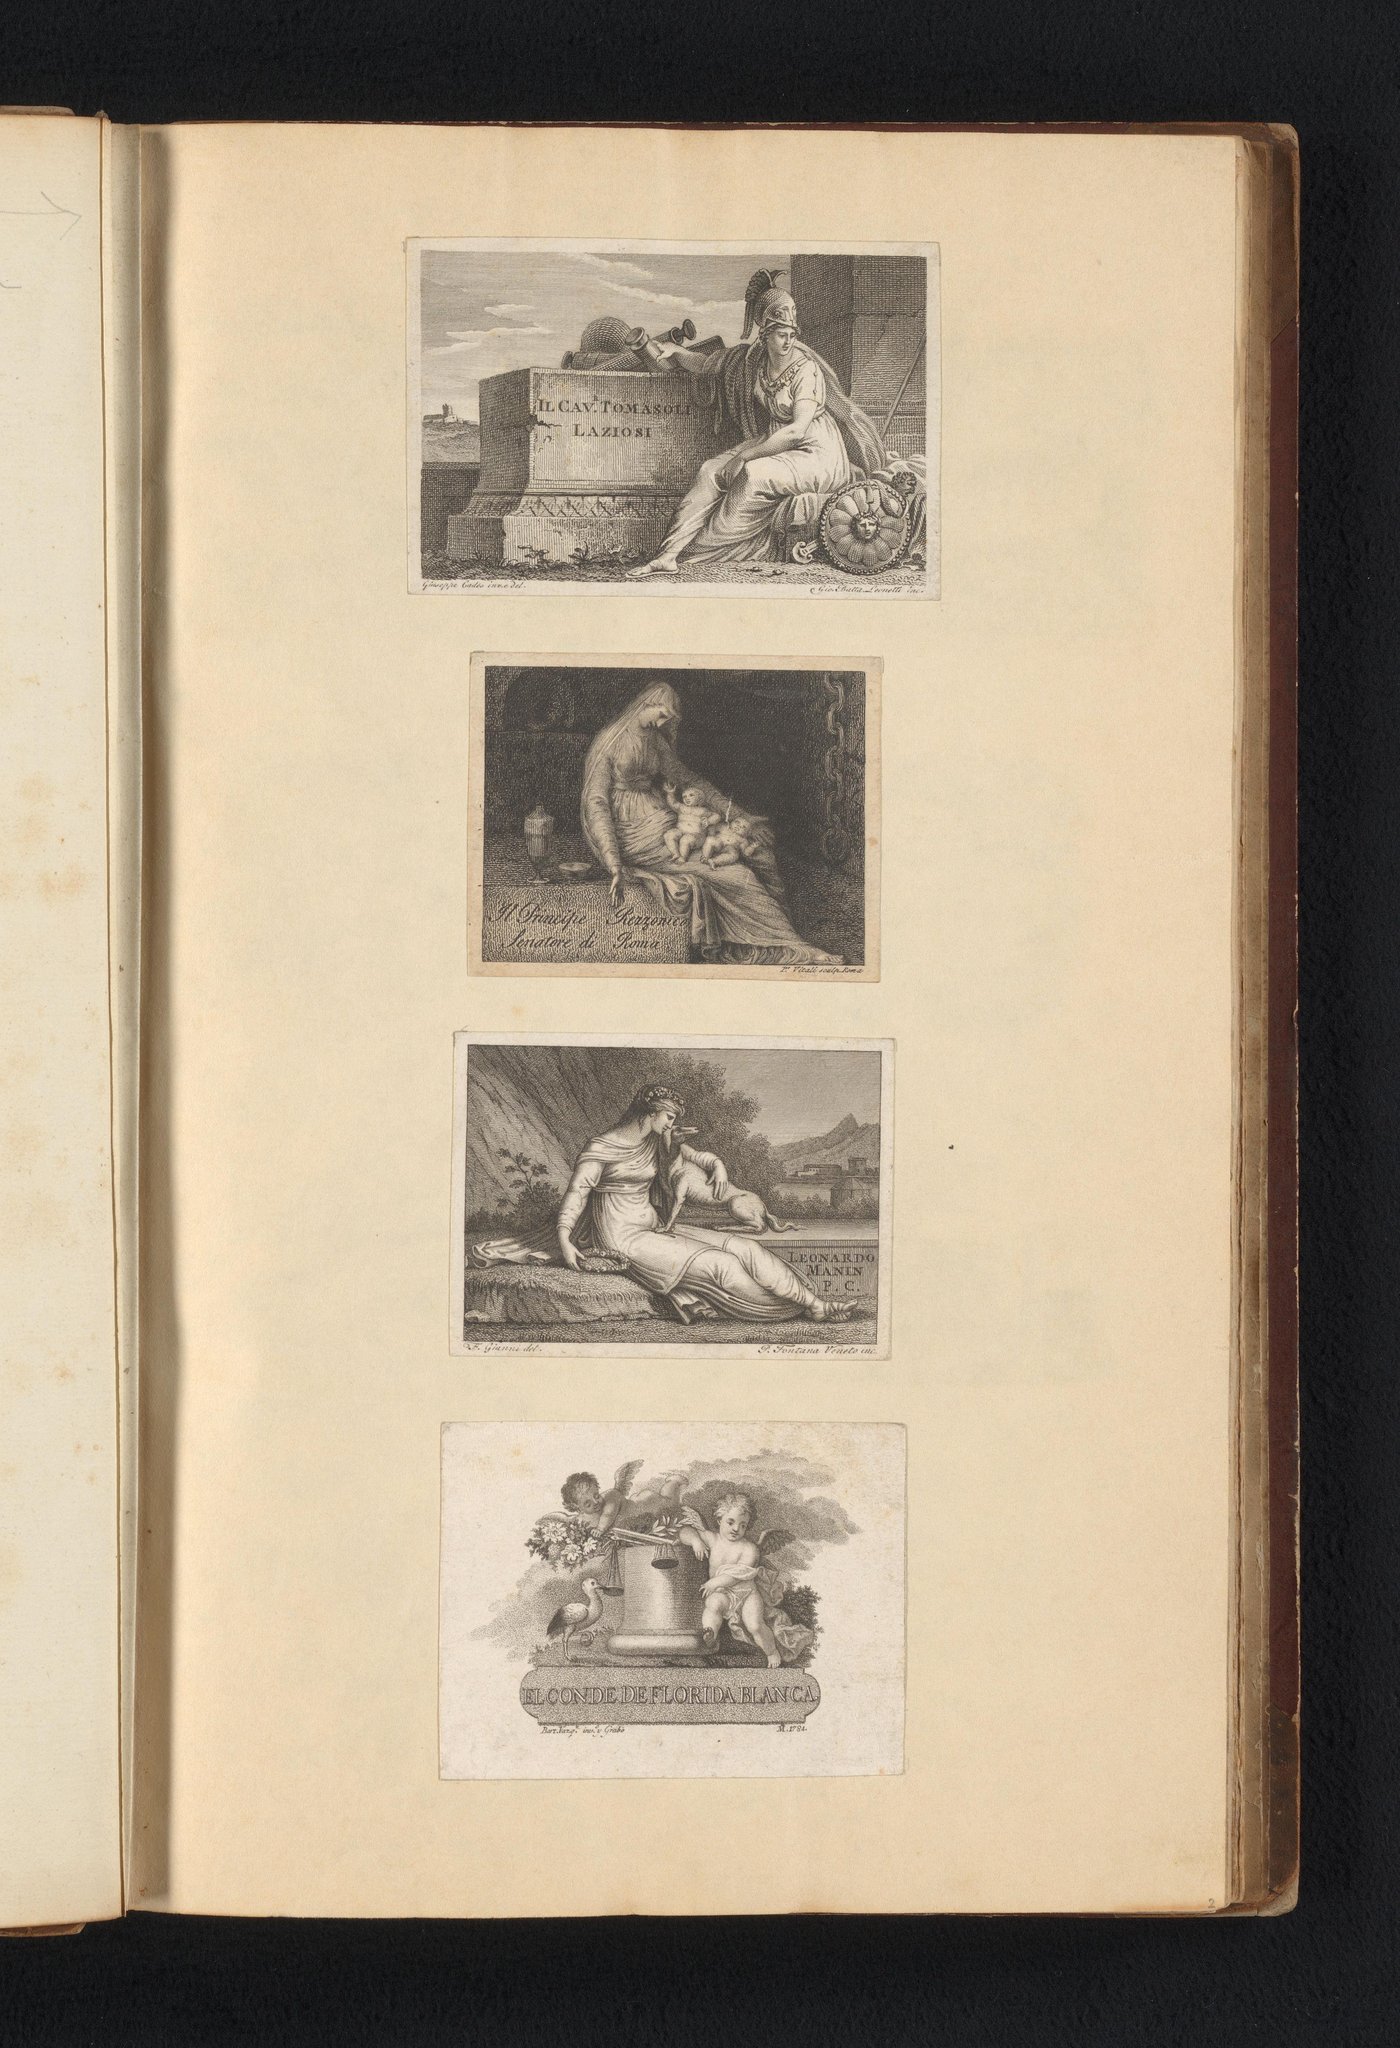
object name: album leaf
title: Allegorische vignetten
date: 1750-1816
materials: paper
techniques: engraving, etching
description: Vier allegorische vignetten met zittende vrouwen. Onderdeel van het tweede van twee albums met ingeplakte prenten en tekeningen te dienen als tekenvoorbeelden.